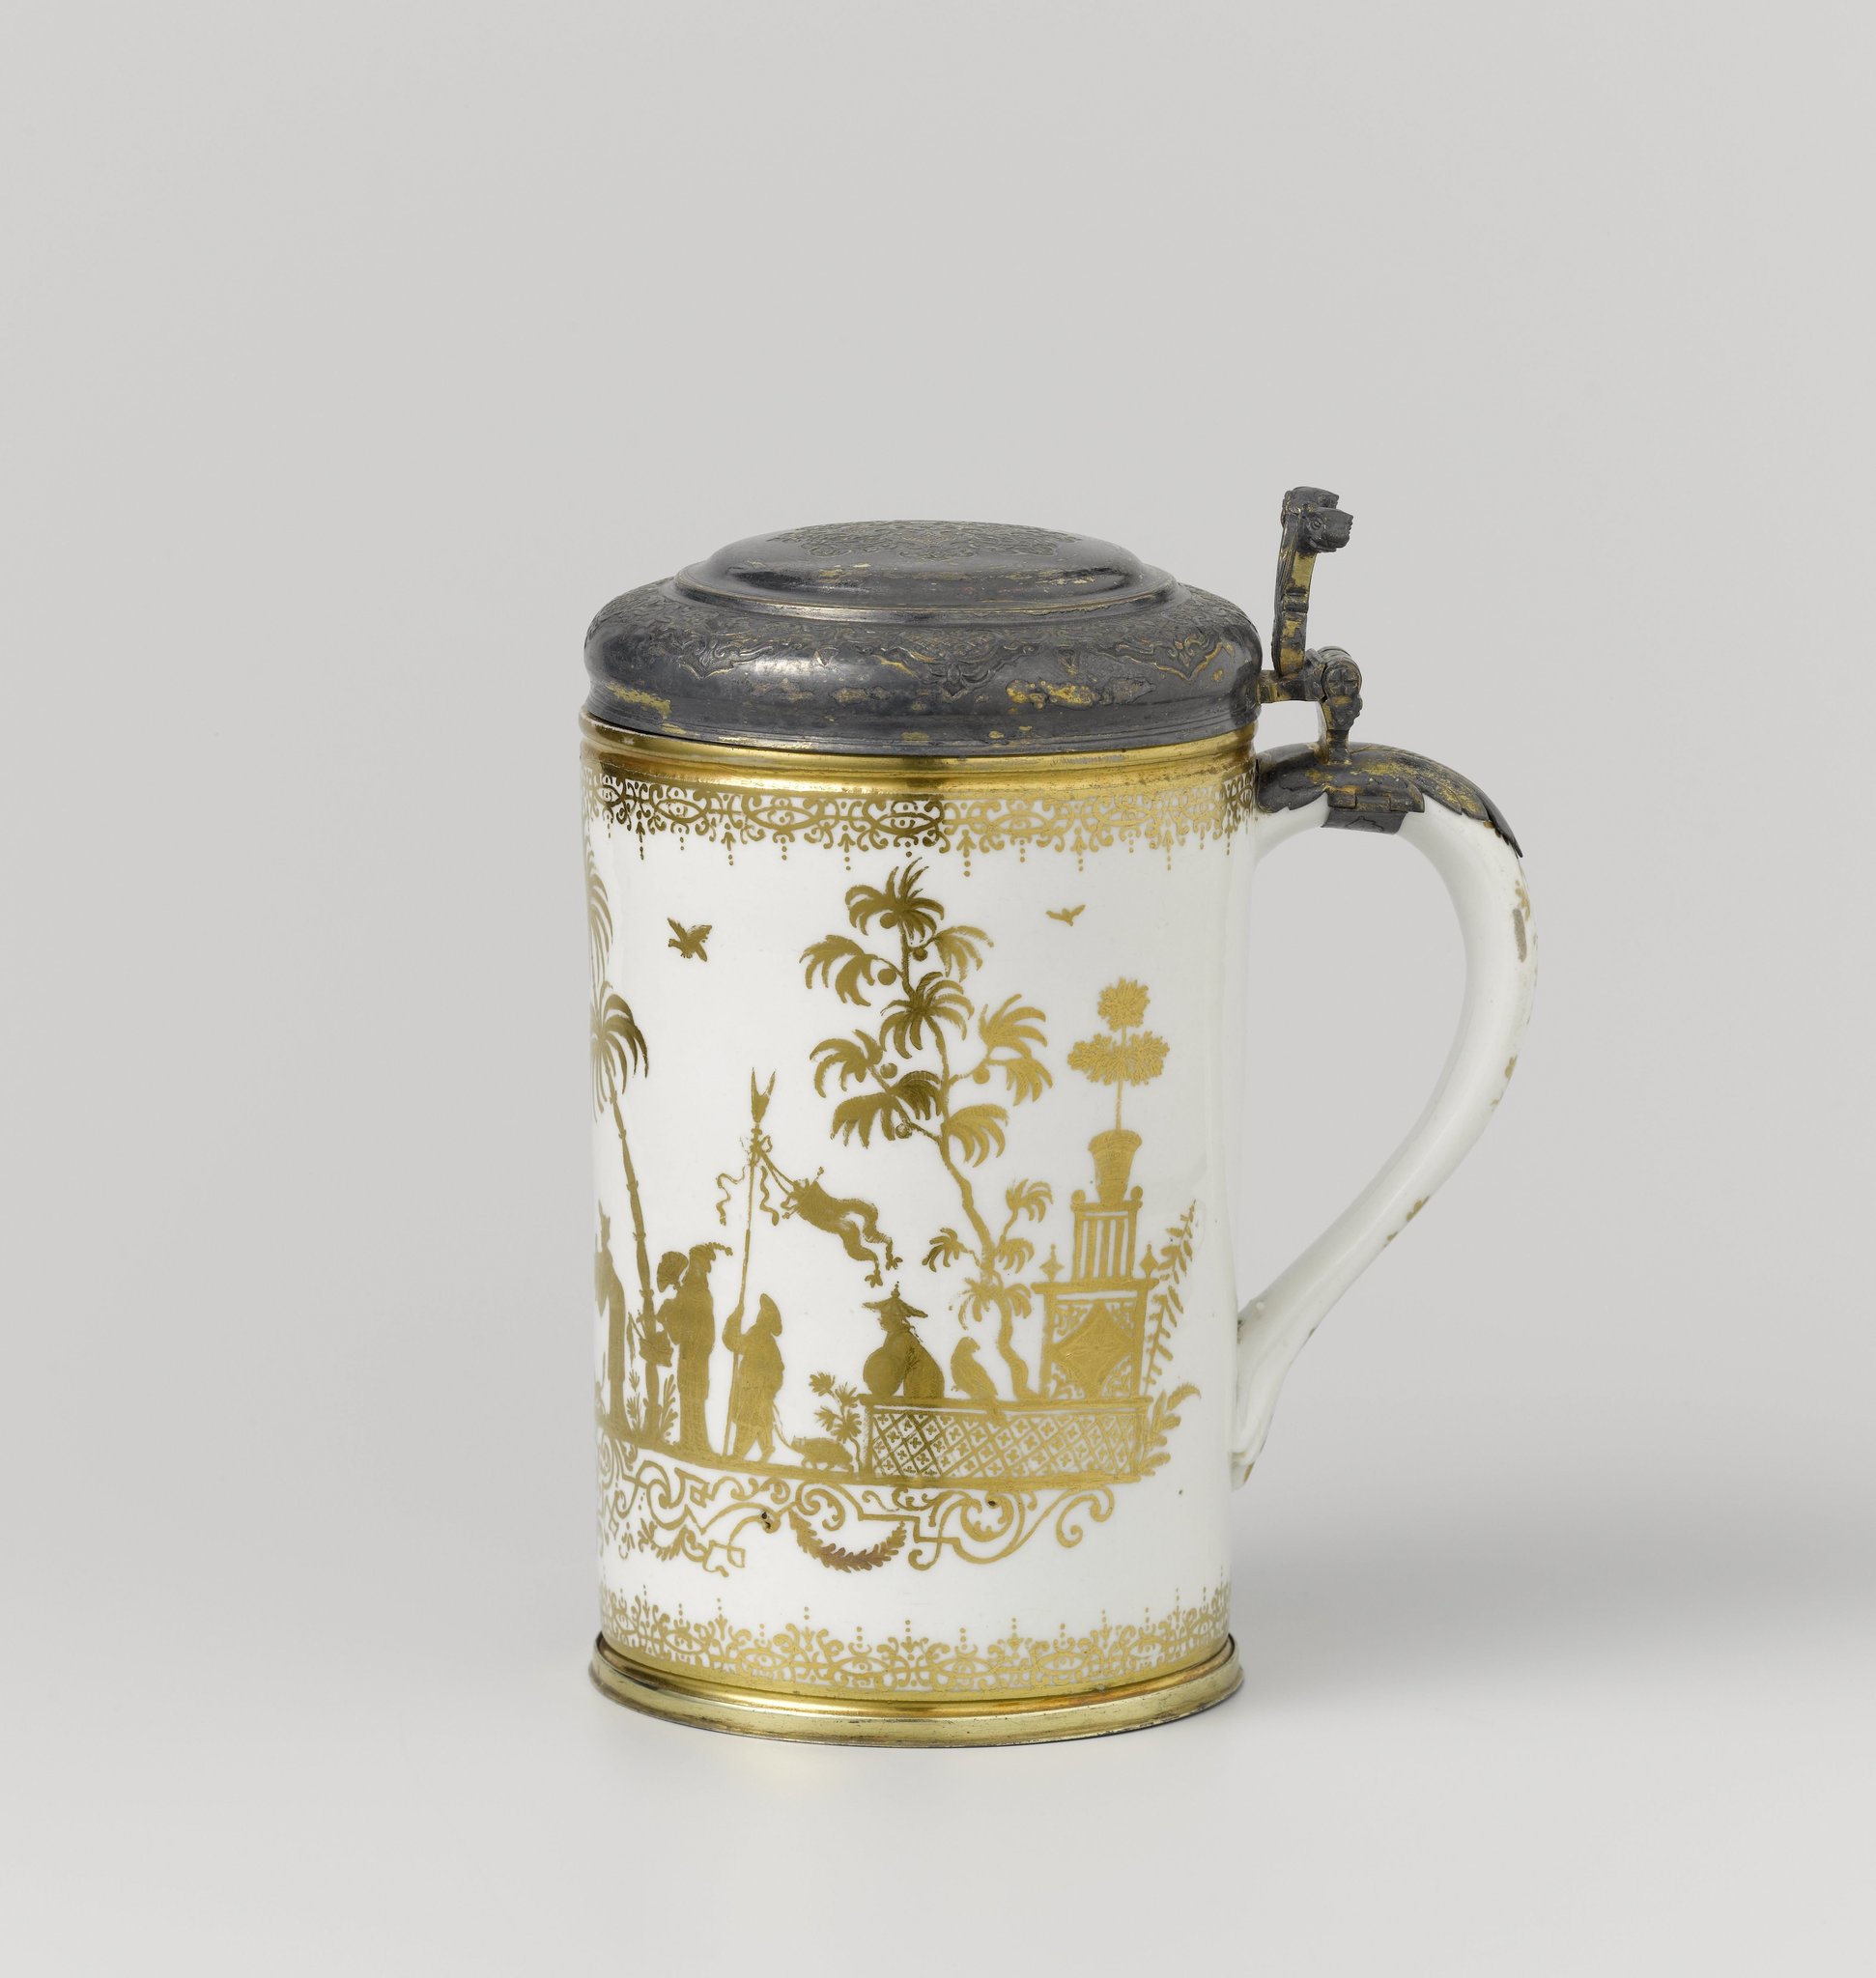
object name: eating drinking utensil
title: Tankard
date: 1725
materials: porcelain, silver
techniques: gilding, painted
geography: meissen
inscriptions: maker's mark: ‘EA’, date letter: ‘A’, number: ‘70.’, town mark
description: Initially the workers at Meissen were barely capable of decorating porcelain. Undecorated porcelain objects were thus sent to Augsburg – 500 kilometres away! – where specialized Hausmaler (independent painters) applied gold ornamentation to them. This type of gold chinoiserie decoration is called Goldchinesen. The gold has been worked with an agate burin to give the scenes greater depth.